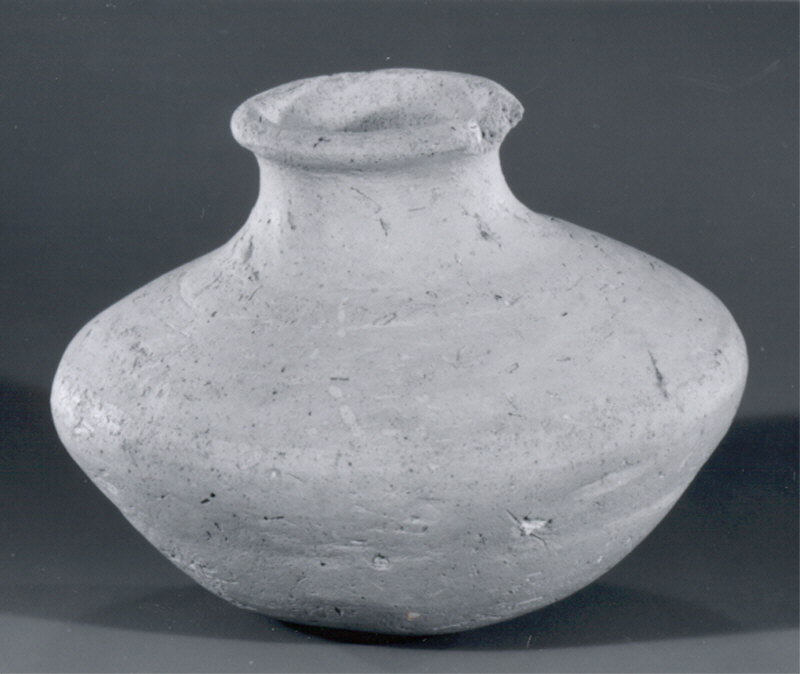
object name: bottle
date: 2333-2001 BCE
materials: ceramic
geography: mesopotamia